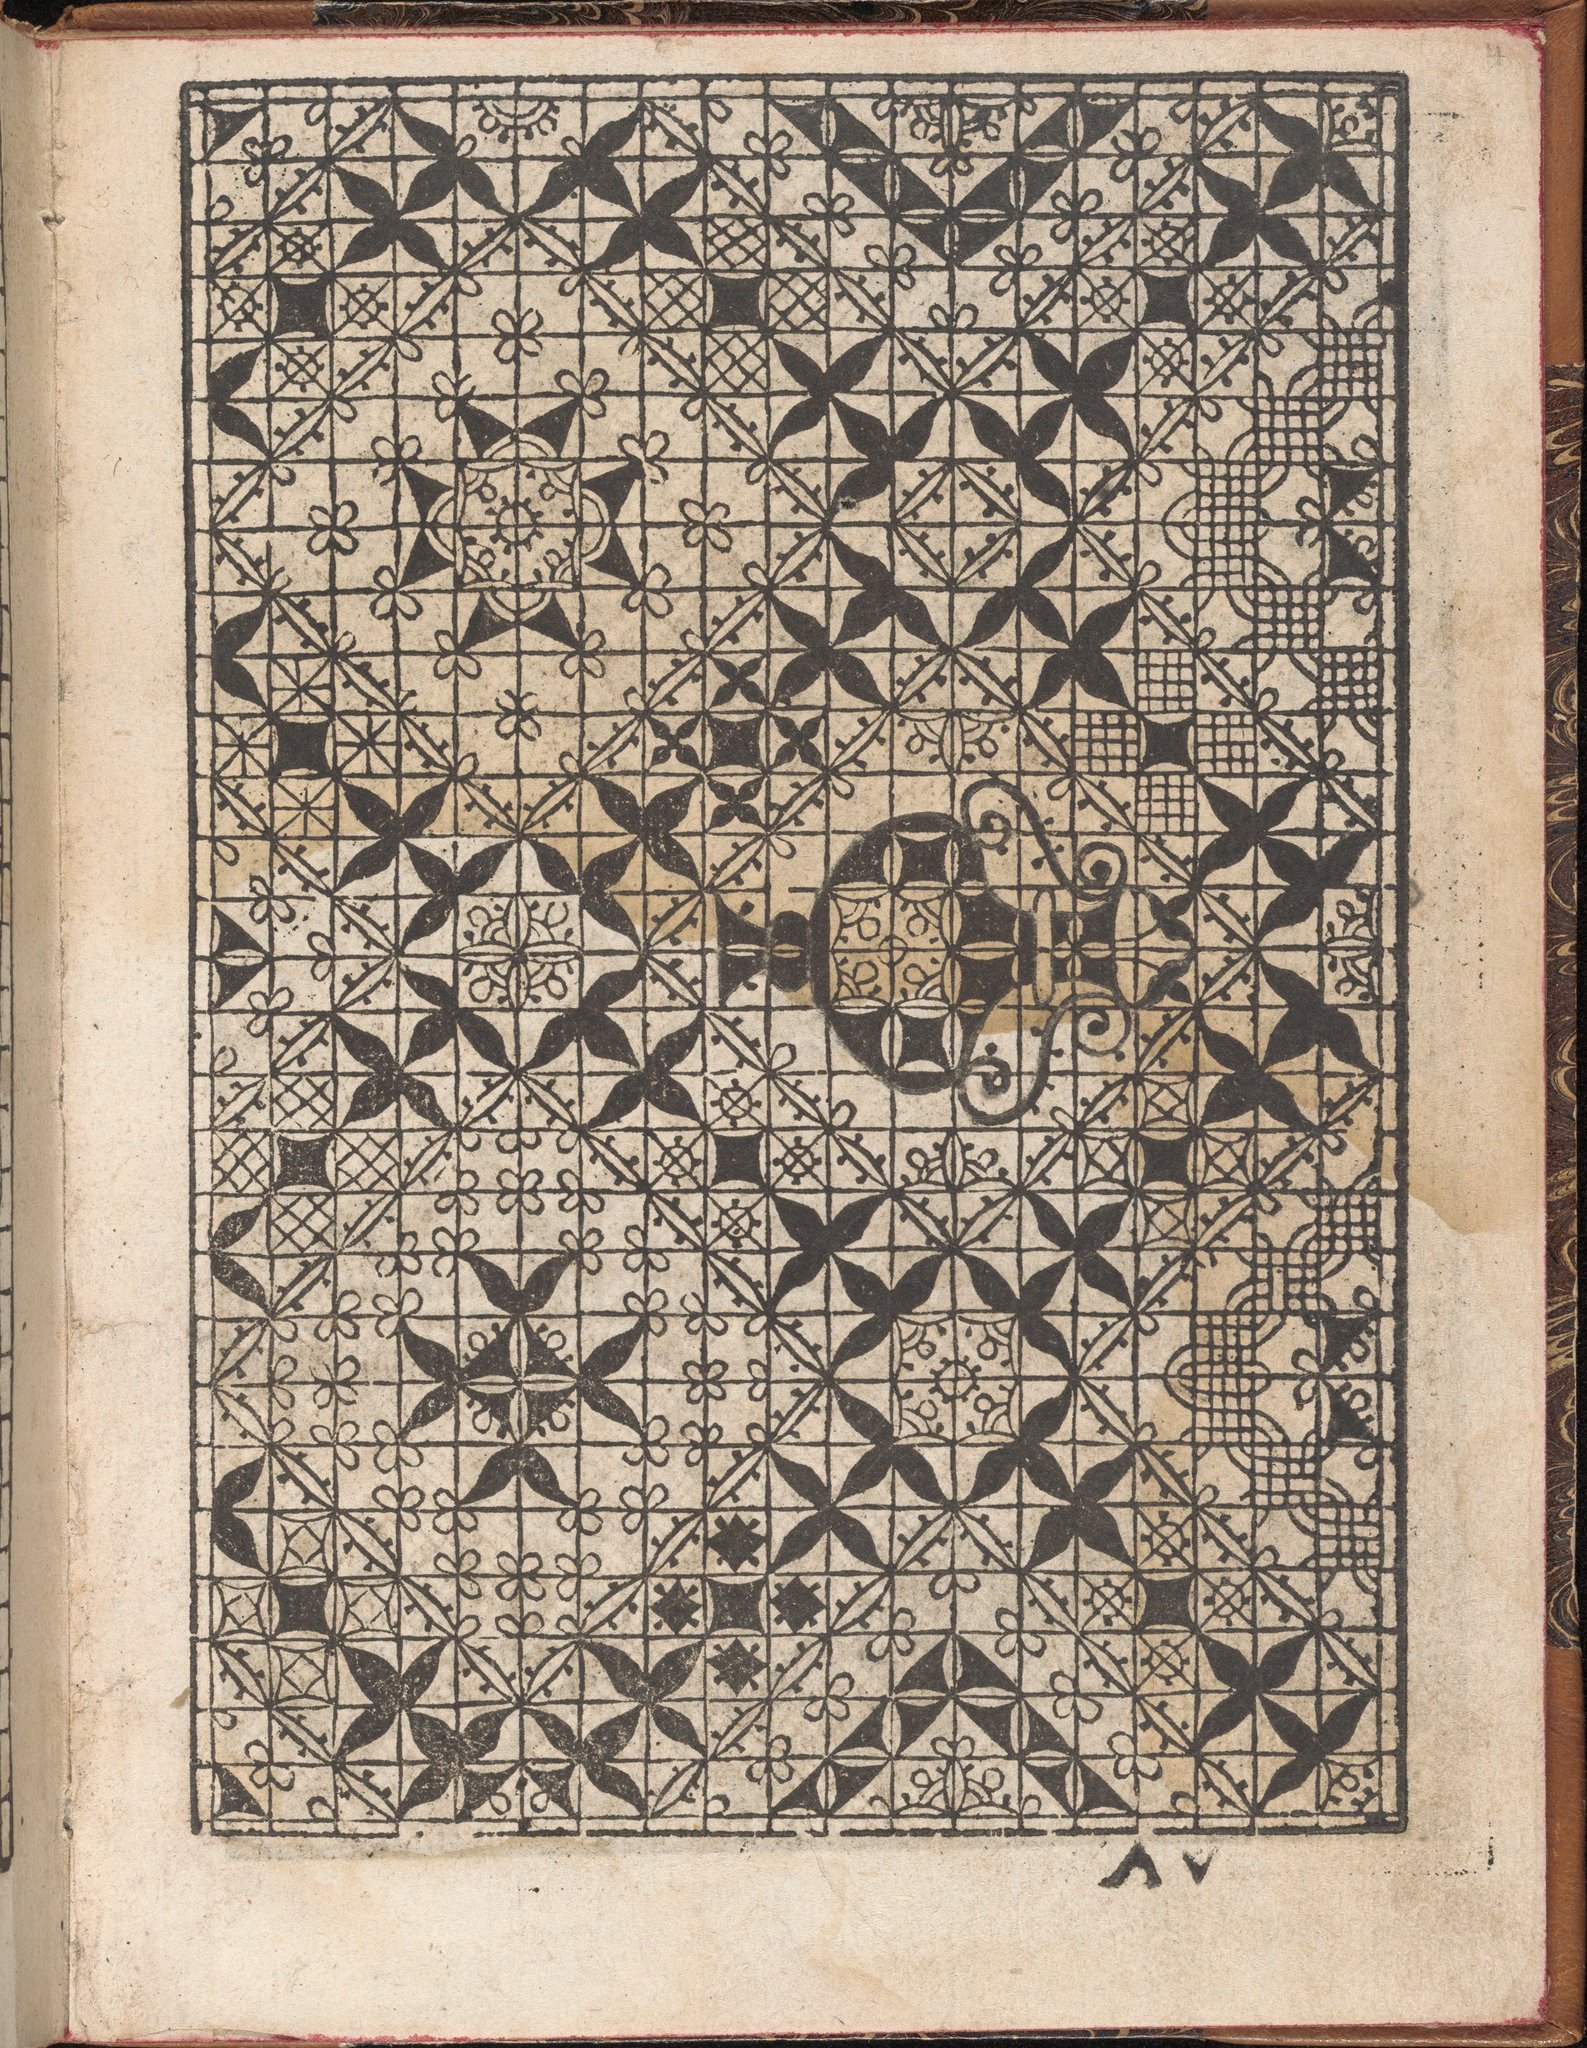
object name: book print ornament architecture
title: Spechio di pensieri delle belle et Virtudiose donne, page 4 (recto)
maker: matteo pagano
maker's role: publisher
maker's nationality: italian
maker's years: 1515-1588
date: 1546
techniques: woodcut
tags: ornament